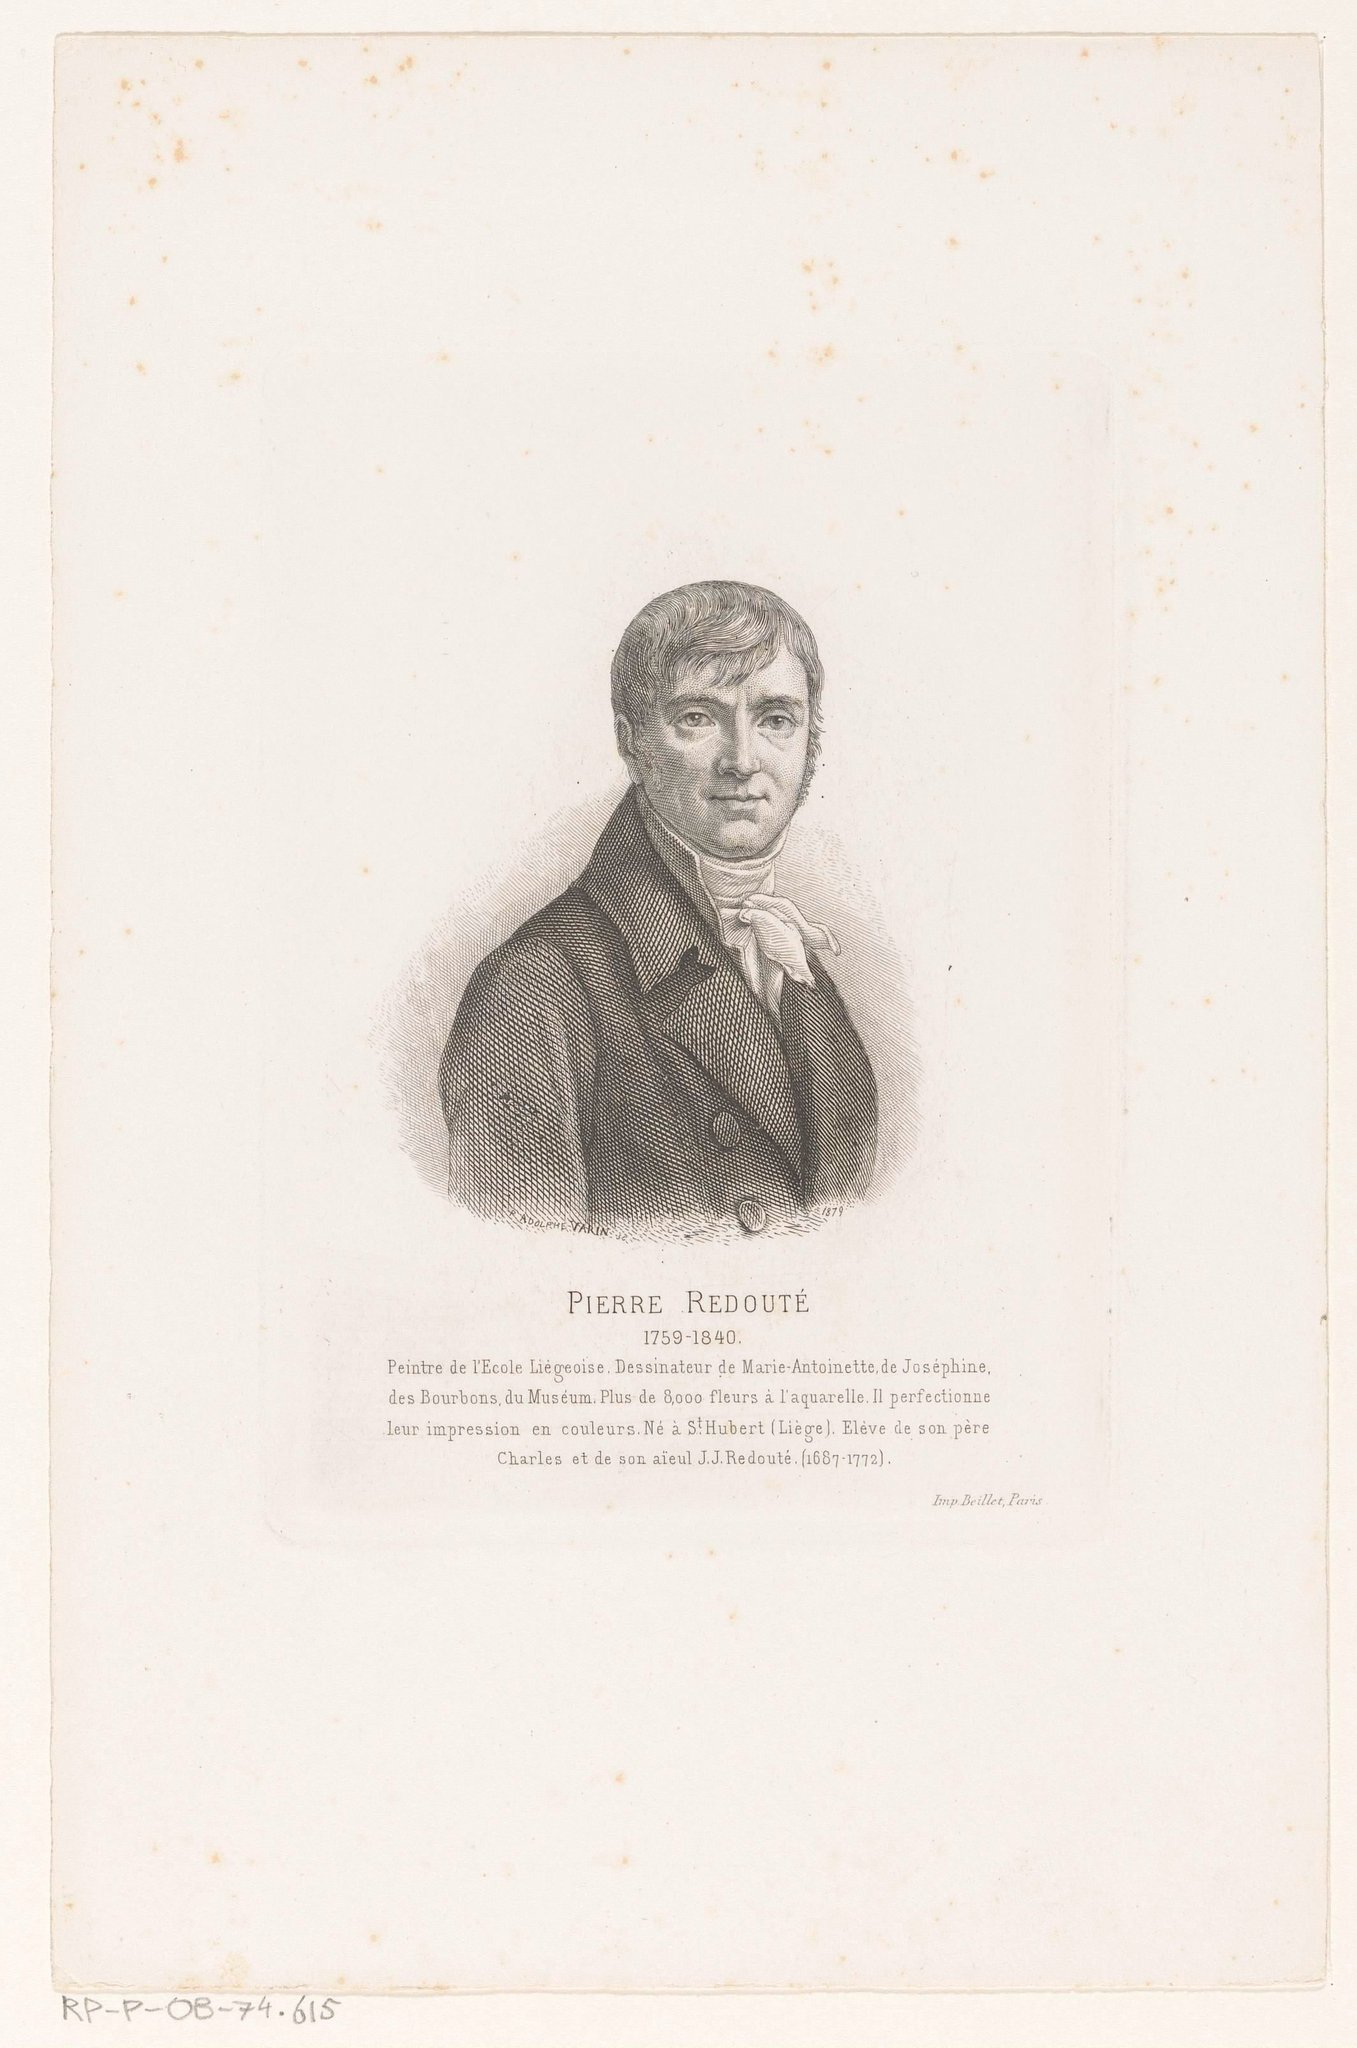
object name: print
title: Portret van Pierre Joseph Redouté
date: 1879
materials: paper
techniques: engraving, etching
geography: paris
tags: print maker, pierre joseph redouté, historical persons, portrait, self-portrait of artist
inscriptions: collector's mark: Lugt 2228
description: Prent uit: École liégeoise. Les Graveurs. Leurs portraits, reproduits au burin, d'après les originaux, par Adolphe Varin, 1366-1850. Avec notes historiques (...). Parijs: Fr. Gobbaerts, ca. 1684.